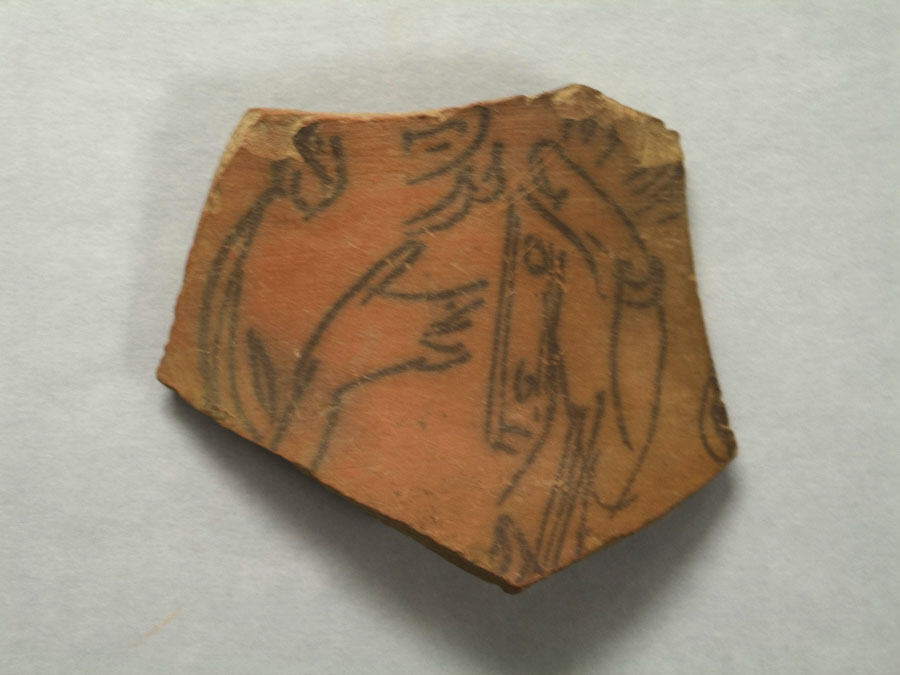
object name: shard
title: Shard: Lower Face and Torso of Chubby Offerer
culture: pakistani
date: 301-500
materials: terracotta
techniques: painting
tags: human figures,gandhara